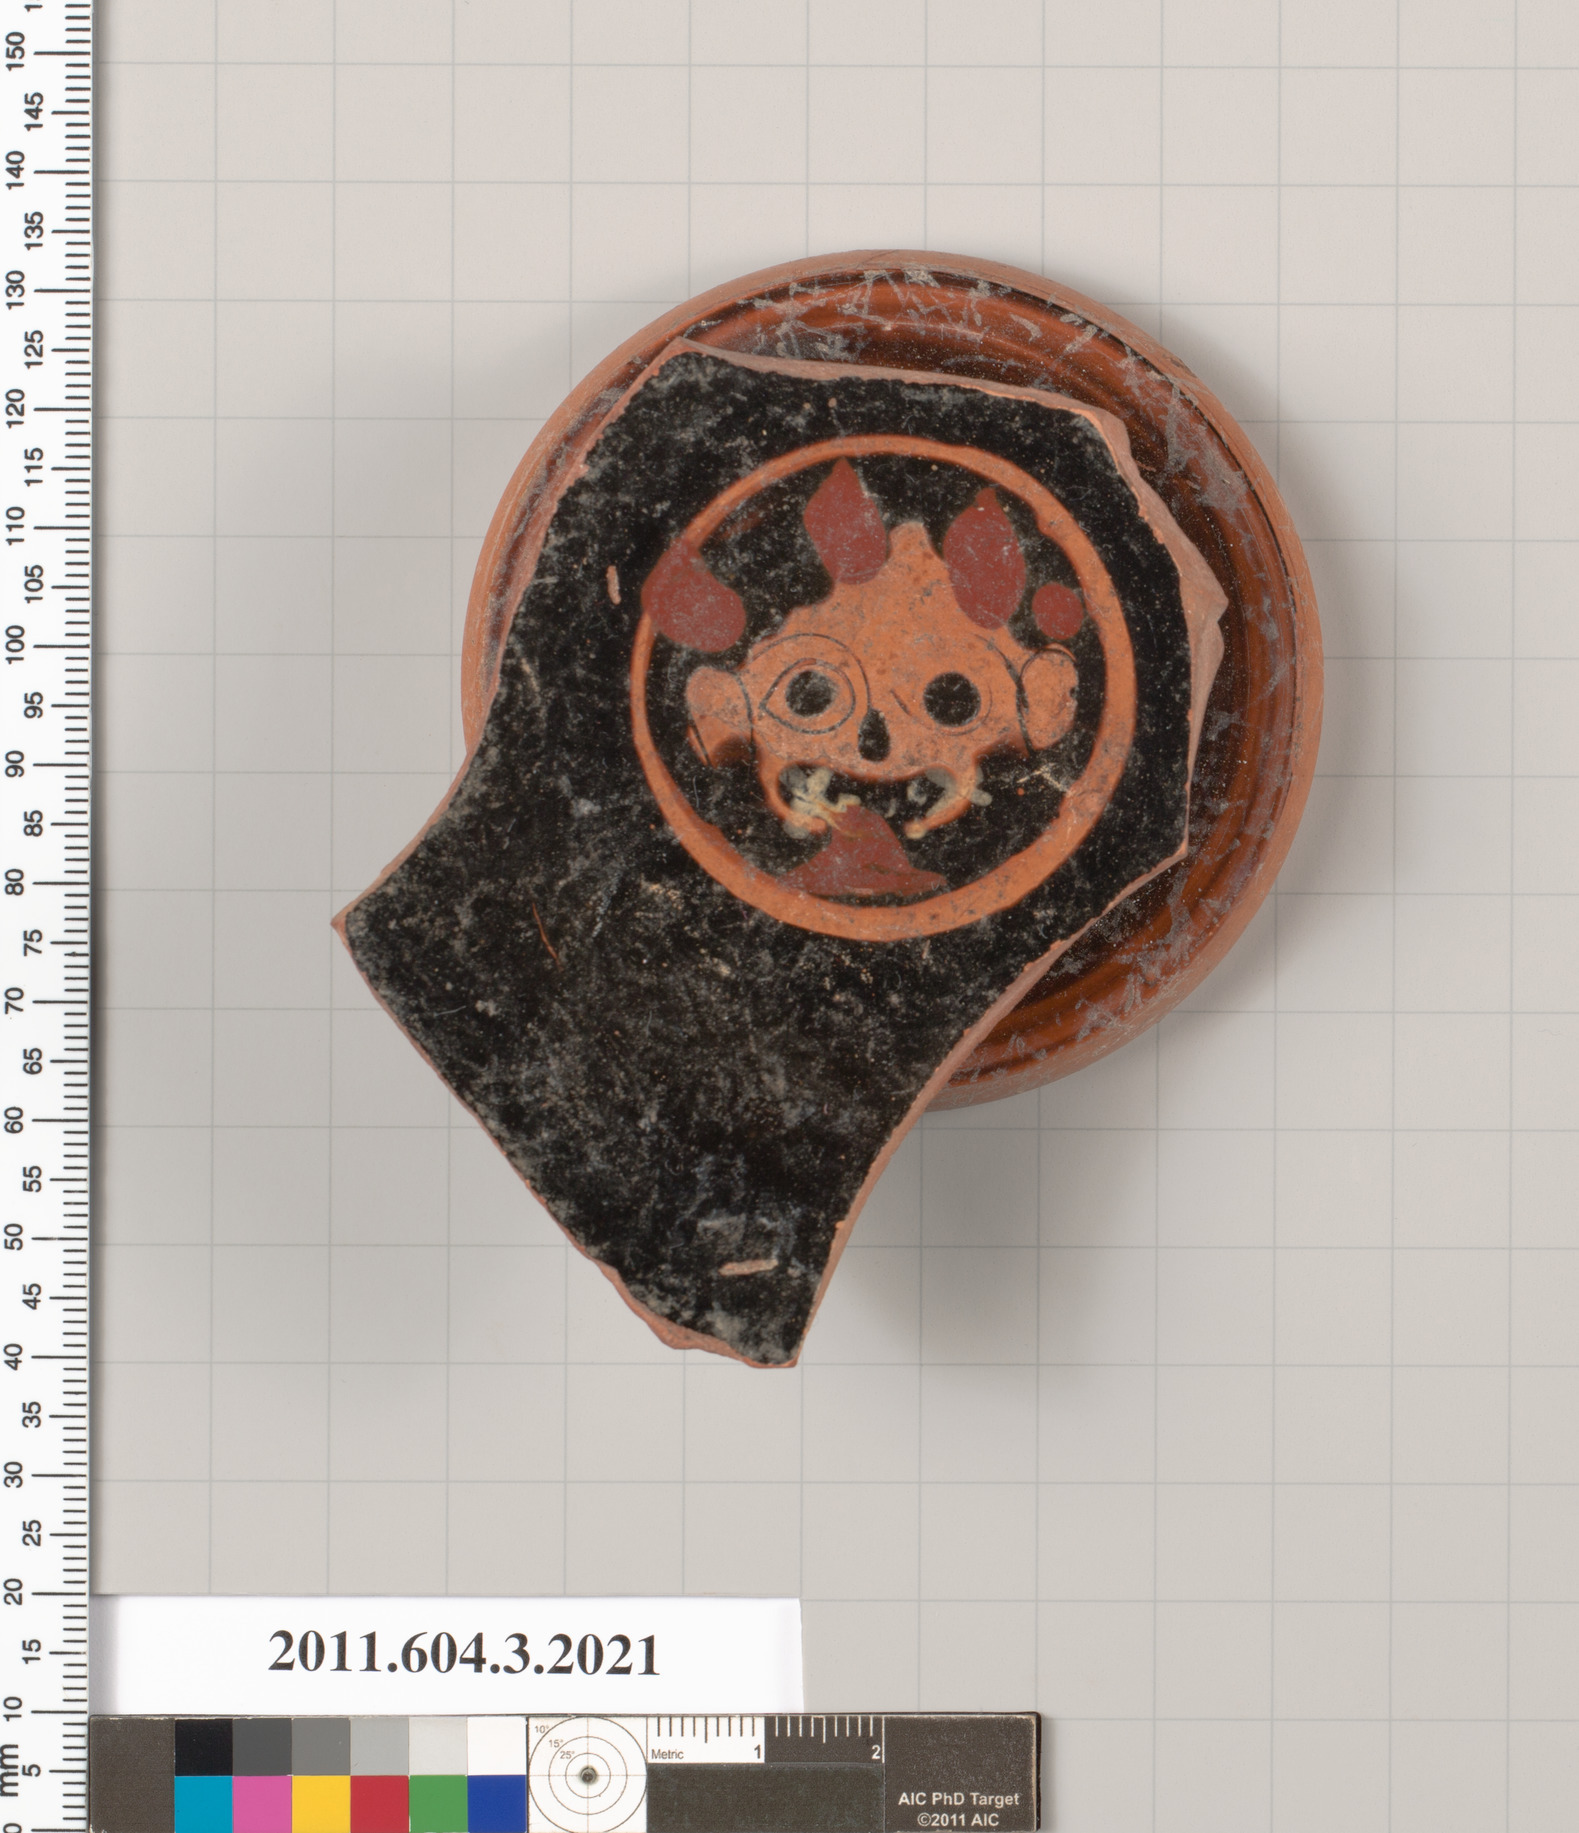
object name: kylix fragment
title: Terracotta fragment of a kylix (drinking cup)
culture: greek, attic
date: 550-526 BCE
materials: terracotta